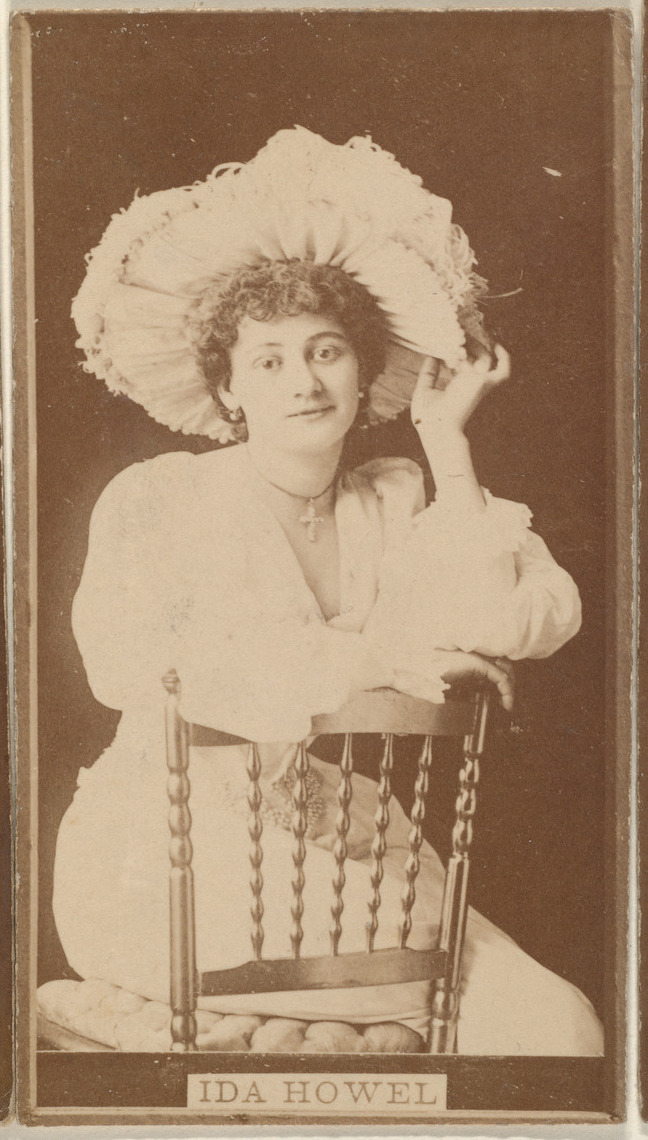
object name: photograph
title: Ida Howel, from the Actresses series (N668)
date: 1888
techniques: albumen silver print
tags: portraits,women,actresses